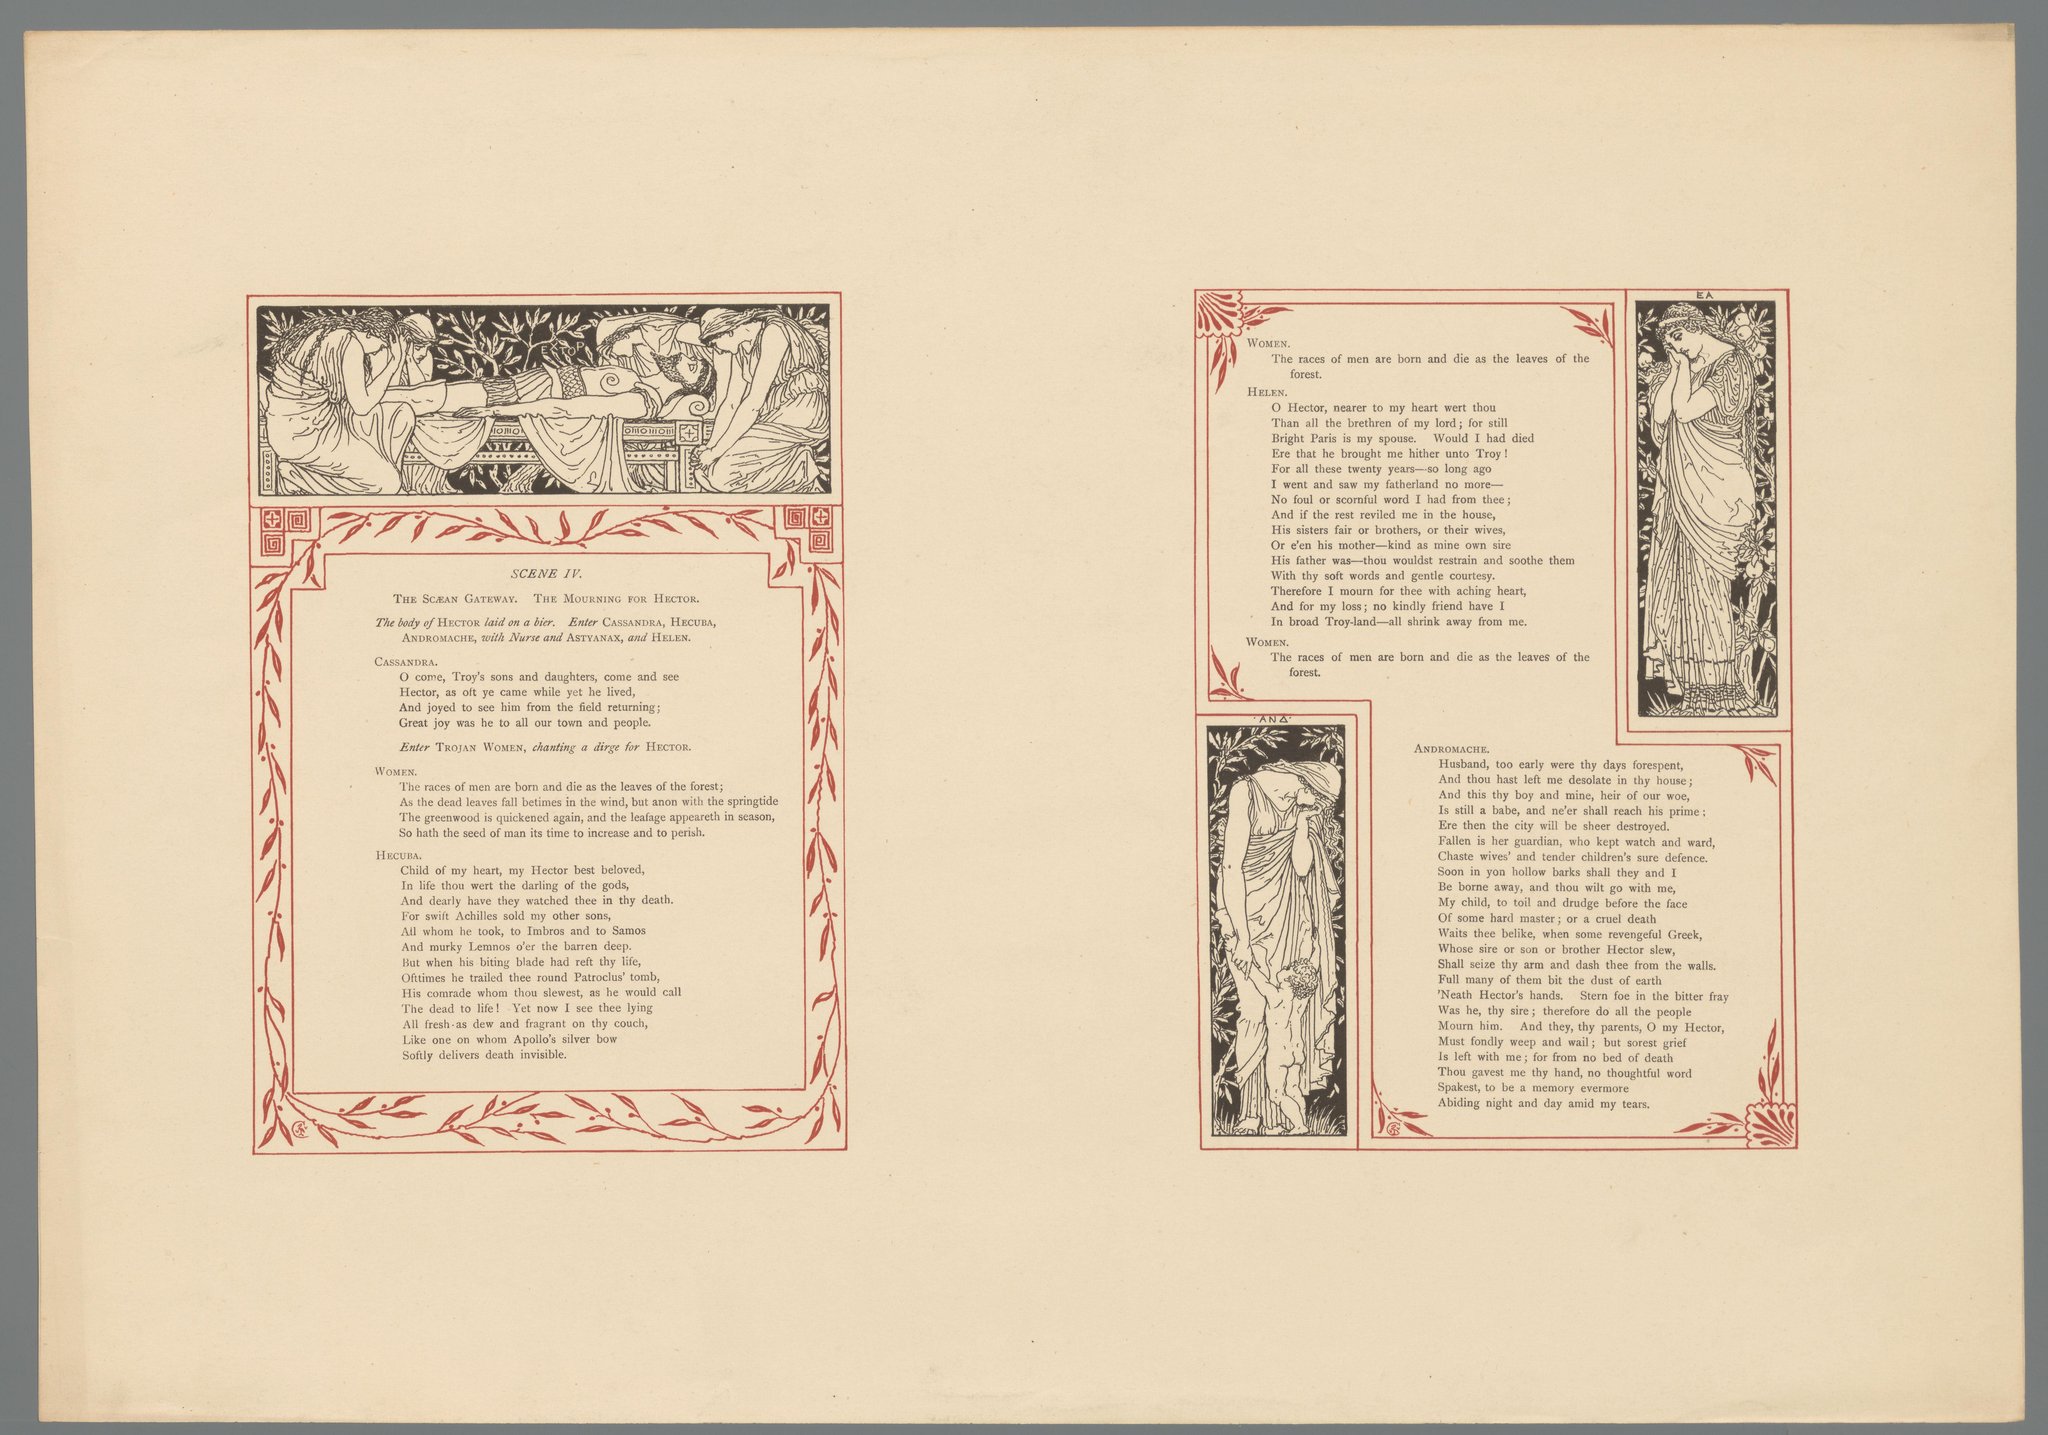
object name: book illustration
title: Wenende vrouwen bij het lichaam van Hector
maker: walter crane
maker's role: draughtsman, print maker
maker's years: 1845-1915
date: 1887-1888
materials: paper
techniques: letterpress printing, lithograph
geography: london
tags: (story of) hecuba, (story of) cassandra, funeral and mourning of hector, (story of) helen, (story of) andromache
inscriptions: collector's mark: Lugt 2228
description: Prent uit: Warr, George C. Echoes of Hellas: the tale of Troy & the story of Orestes from Homer & Aeschylus. Londen: Marcus Ward & Company, [1887/1888].